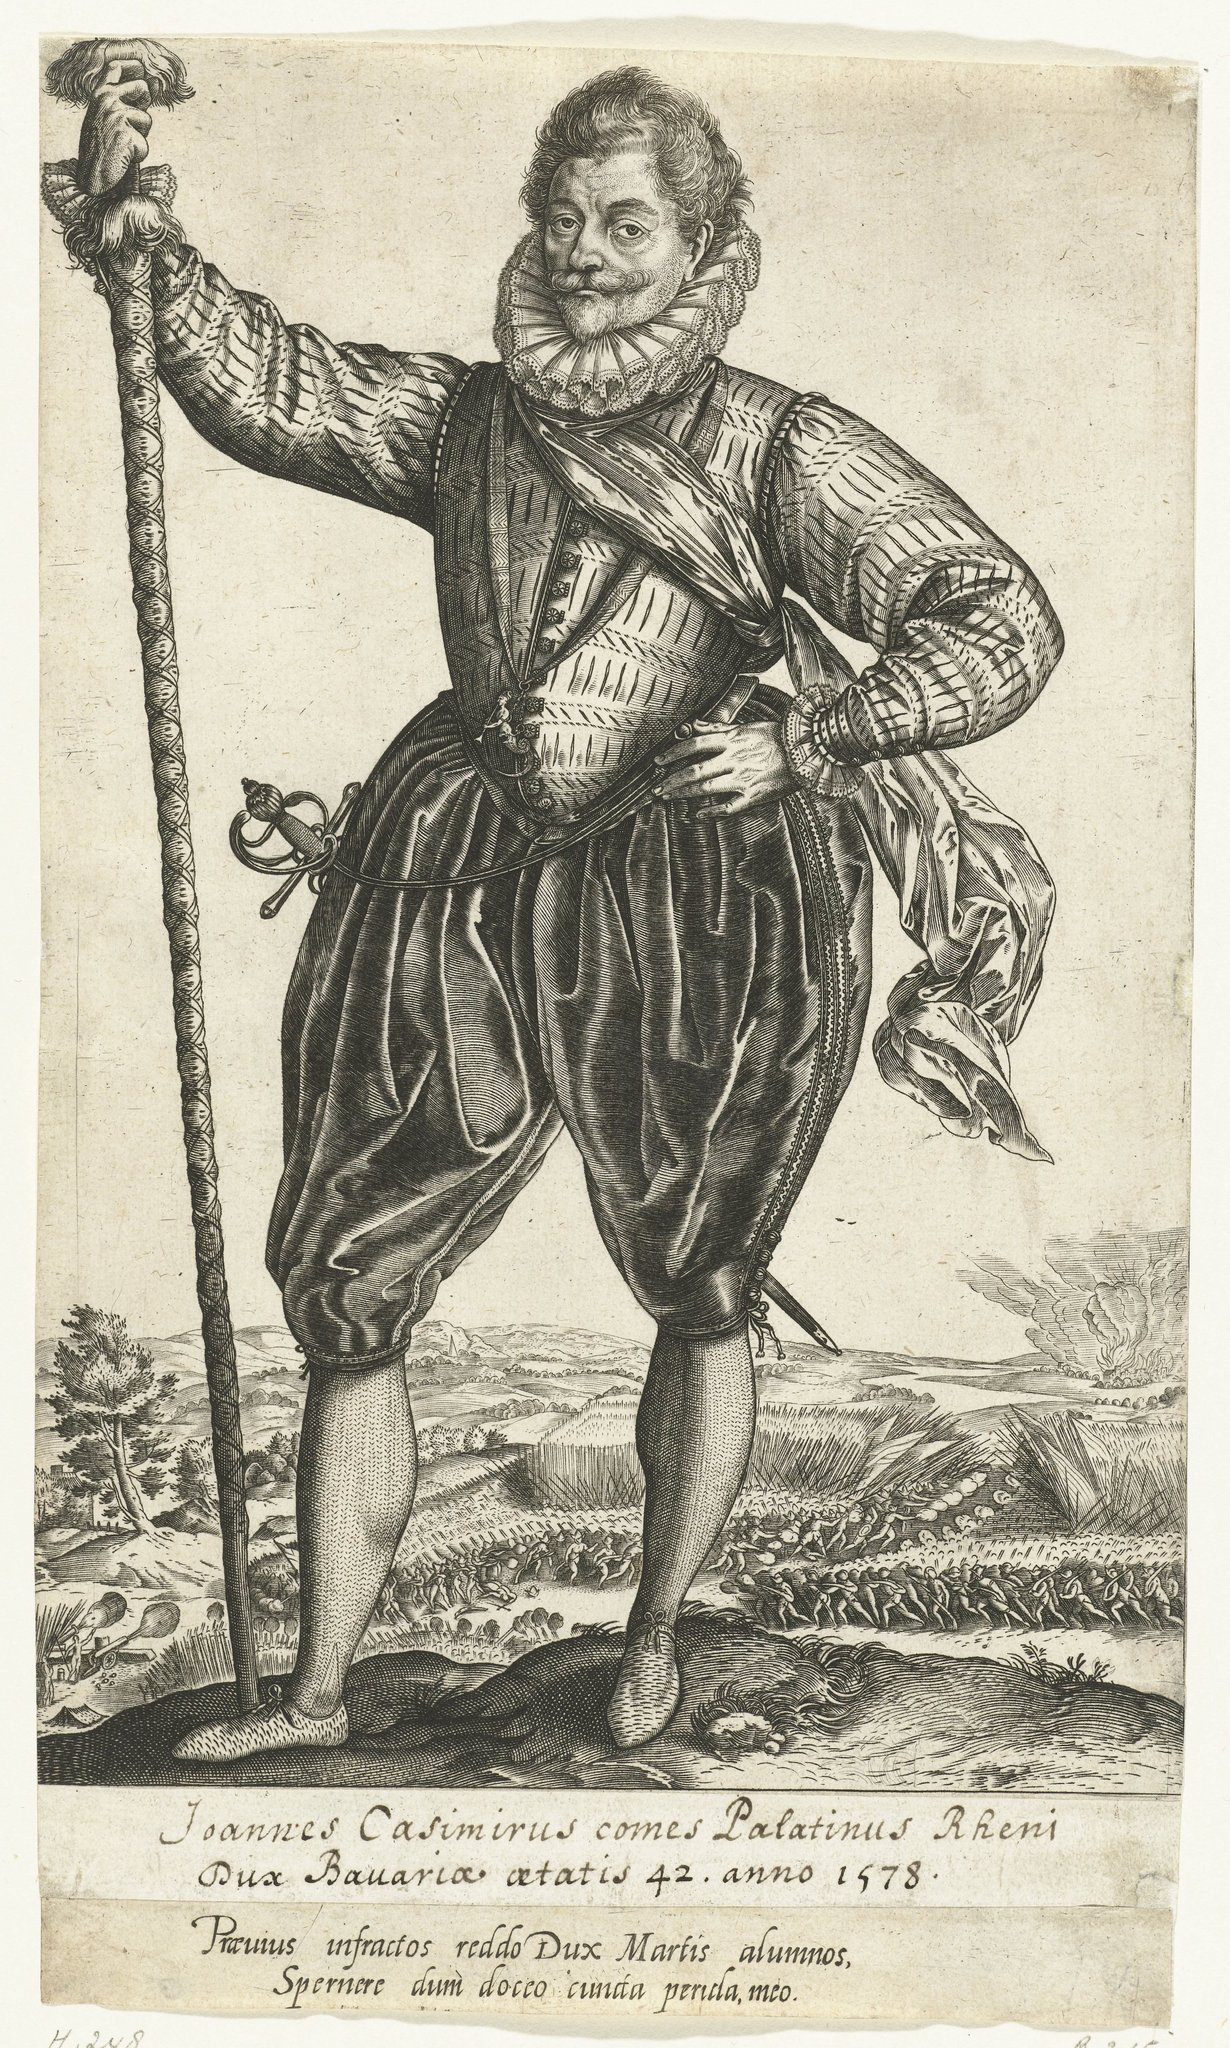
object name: print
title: Kapitein van de infanterie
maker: Anonymous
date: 1583-1600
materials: paper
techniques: engraving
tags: helved weapons, polearms (for striking, hacking, thrusting)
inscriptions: number: ‘N 2342’, collector's mark: Lugt 2228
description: Portret van een man met (waarschijnlijk) een partizaan (stokwapen) in zijn linkerhand. Voorheen ook wel geidentificeerd als Gerrit de Jong, N. Blok of Pieter Dz. Hasselaer. Op de achtergrond een veldslag. Onder de voorstelling een handgeschreven titel en twee gegraveerde regels Latijn.